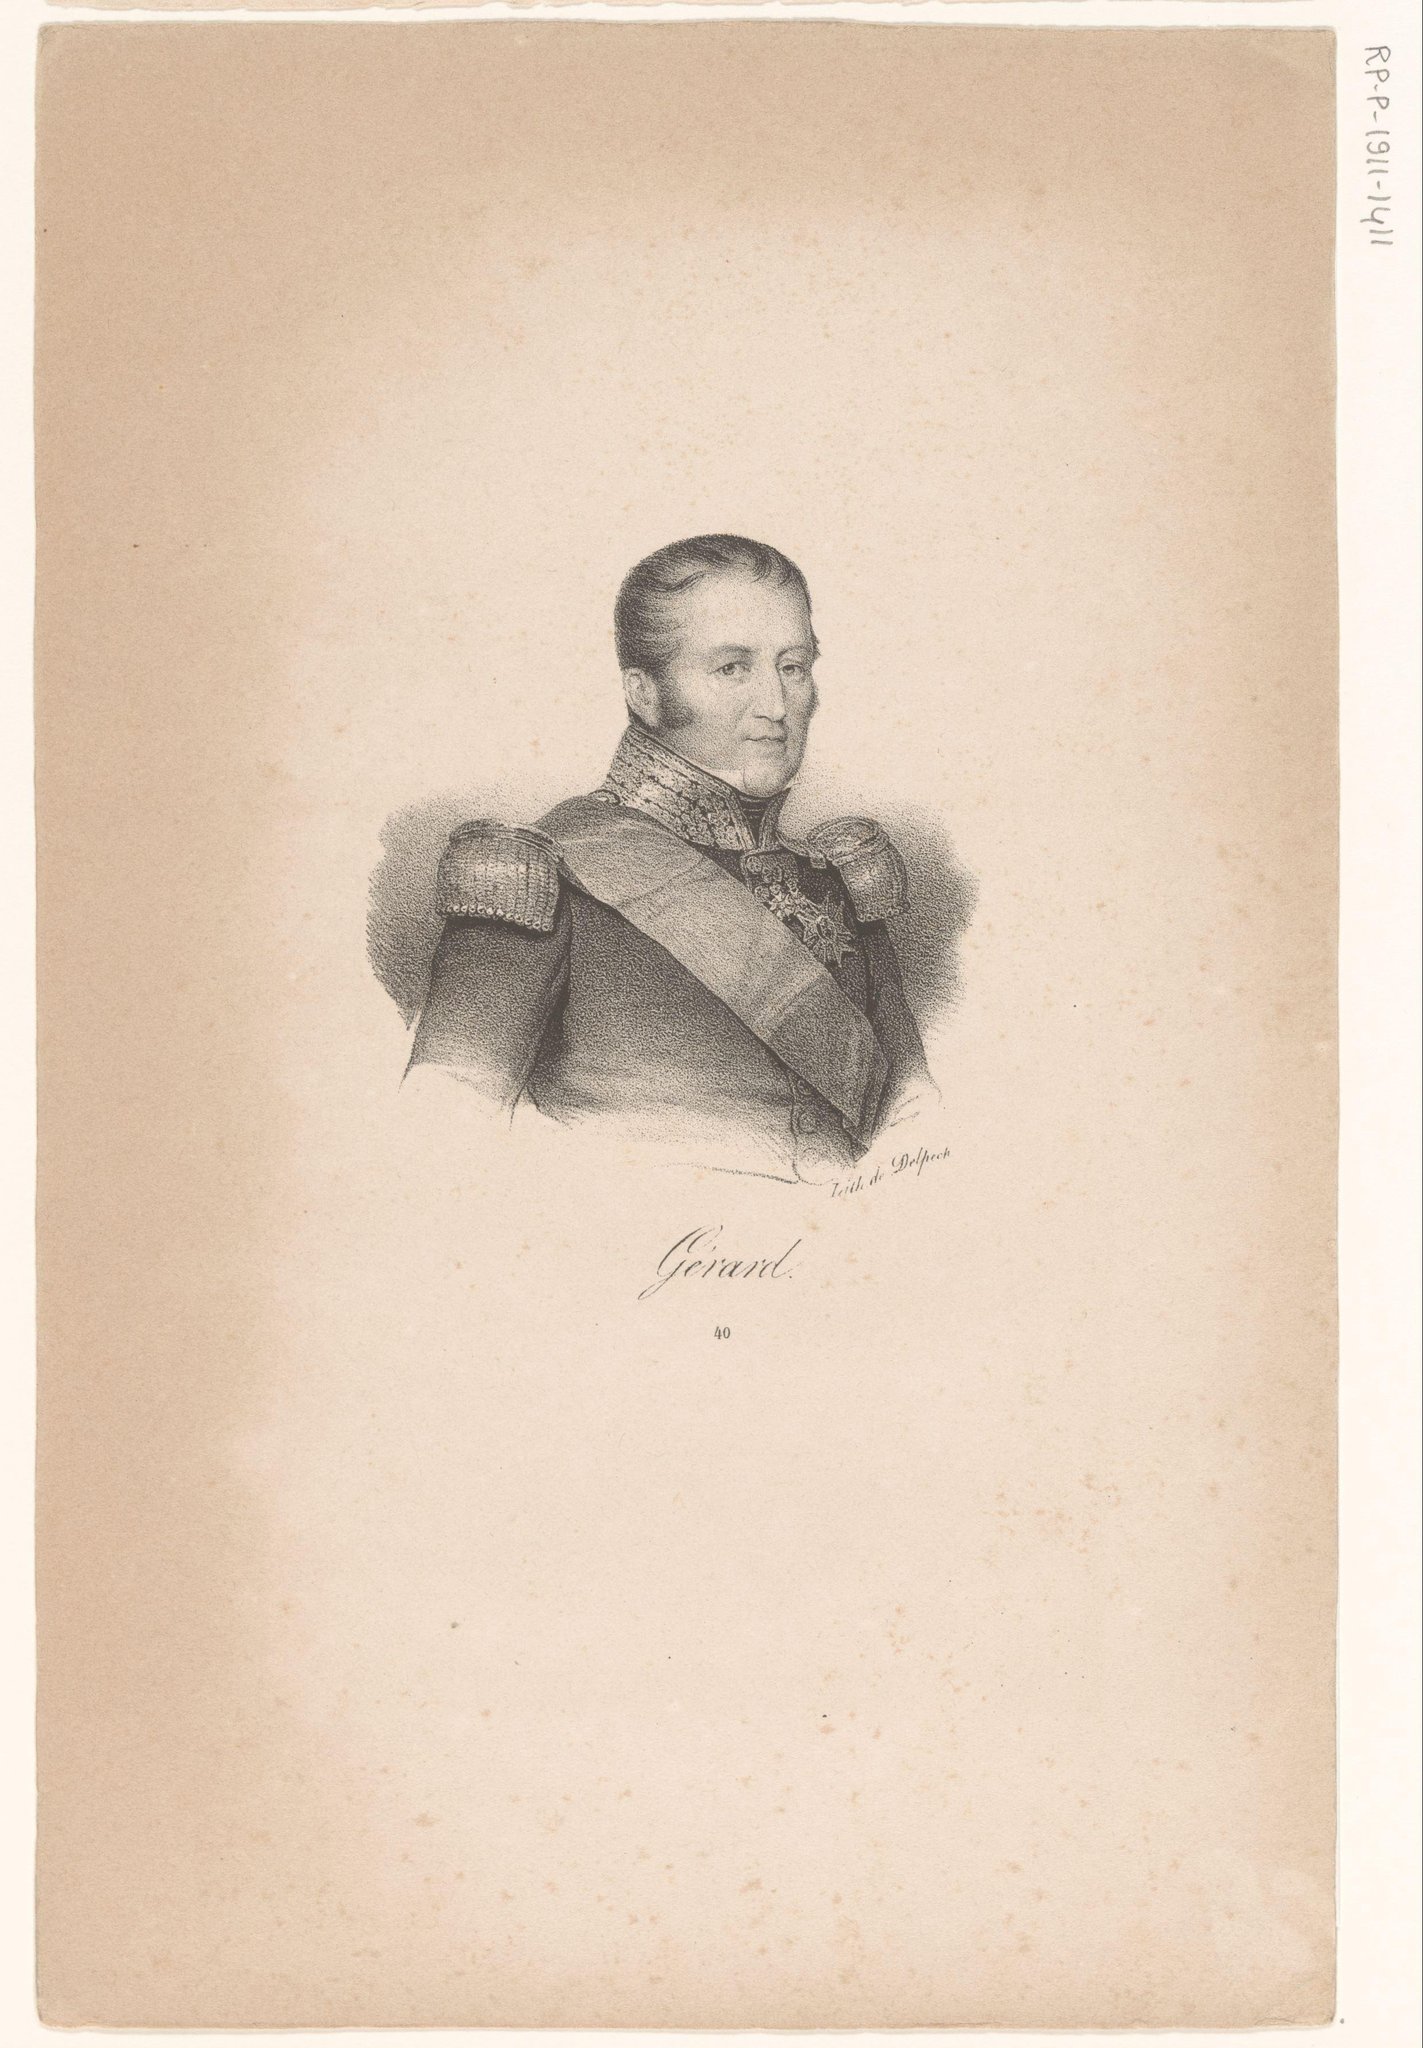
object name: print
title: Gérard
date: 1818-1842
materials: paper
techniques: lithograph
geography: paris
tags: historical persons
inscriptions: collector's mark: Lugt 2228a